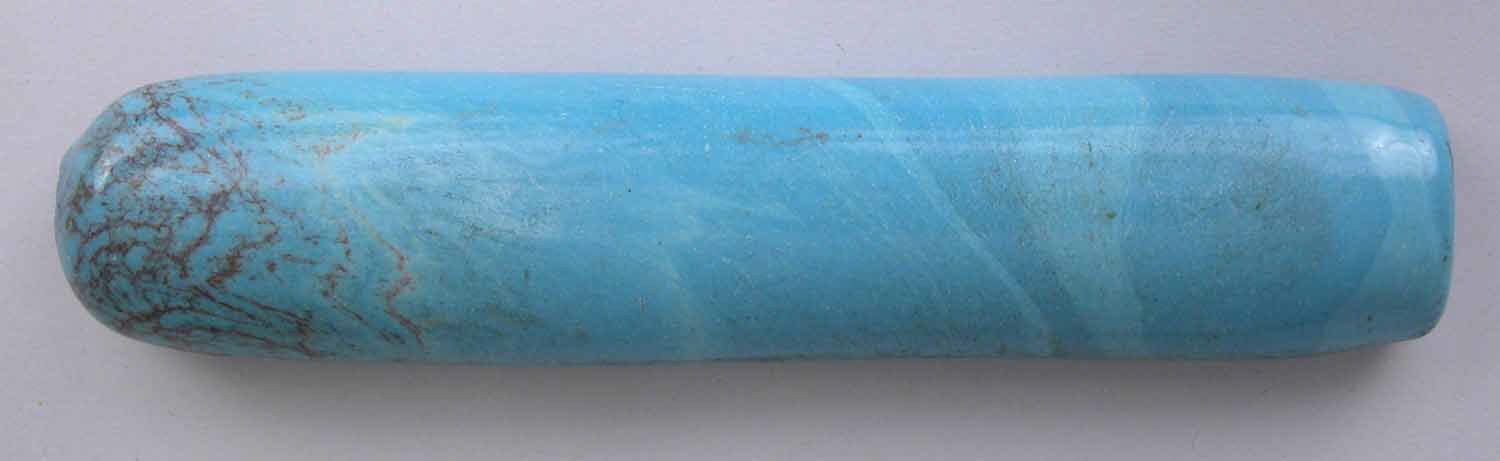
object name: column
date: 1401-1433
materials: glass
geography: egypt